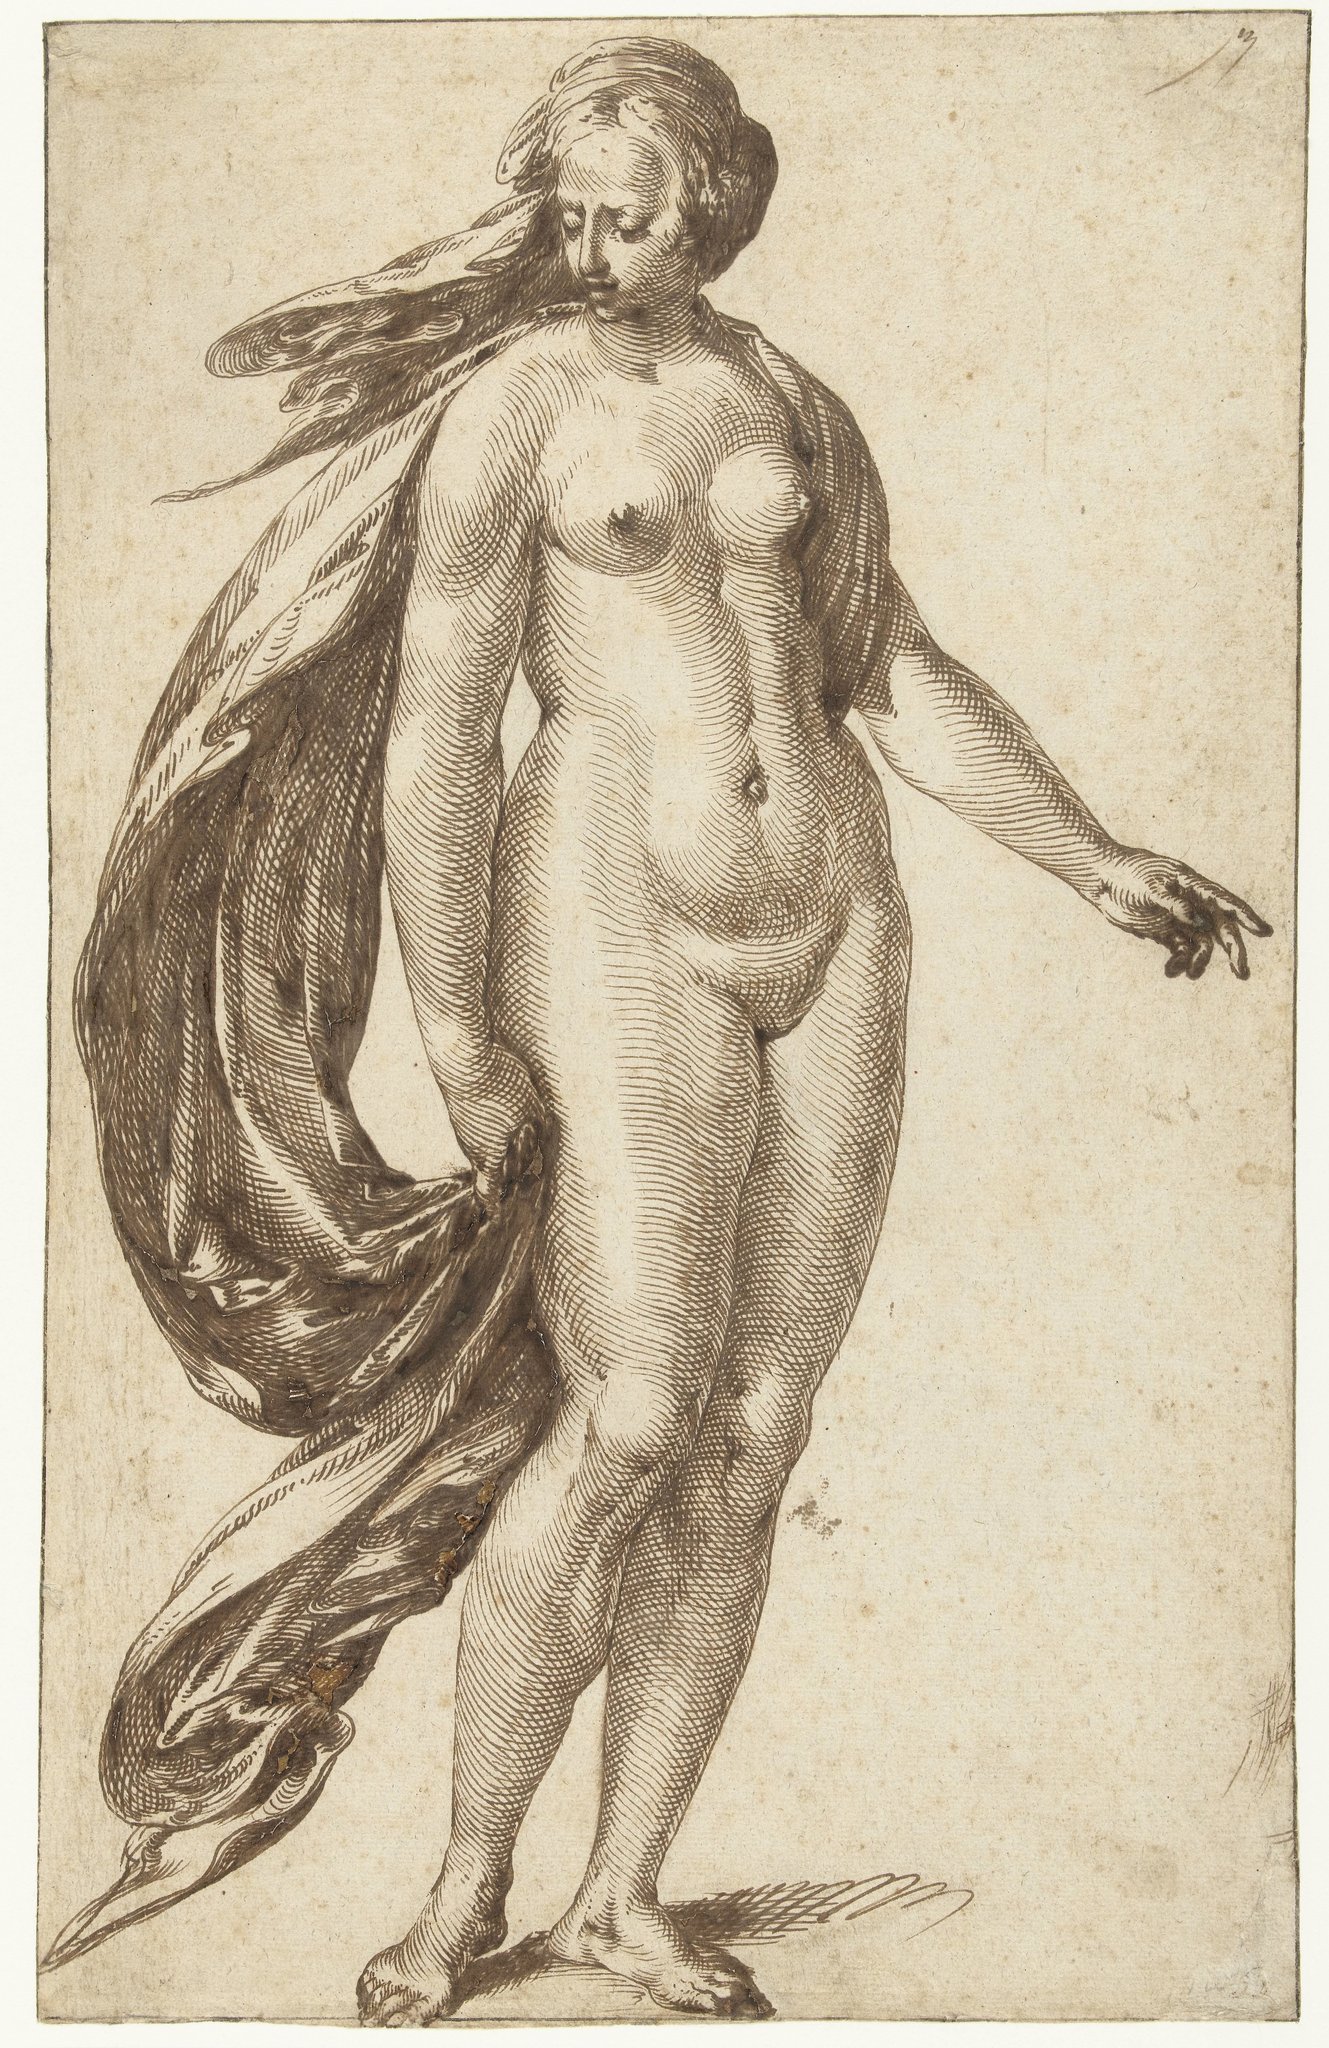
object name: drawing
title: Standing Female Nude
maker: jacques de gheyn (ii)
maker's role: painter, print maker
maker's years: 1565-1629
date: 1575-1679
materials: ink, paper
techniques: pen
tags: standing figure - aa - female human figure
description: I.Q. van Regteren Altena stelde vast dat het (tegenwoordig) moeilijk is vast te stellen of een tekening door J. de Gheyn of door een medewerker van Goltzius is vervaardigt. De tekening echter is aangekocht als een Goltzius. De pentechniek op de tekening van de staande man die een lange mantel draagt, in het British Museum, die A.E. Popham toeschrijft aan De Gheyn, lijkt erg veel op de onze. Beide tekeningen kunnen van een leerling van De Gheyn zijn. (Catalogus van de Nederlandse tekeningen in het Rijksprentenkabinet, Rijksmuseum Amsterdam, Vol. II).